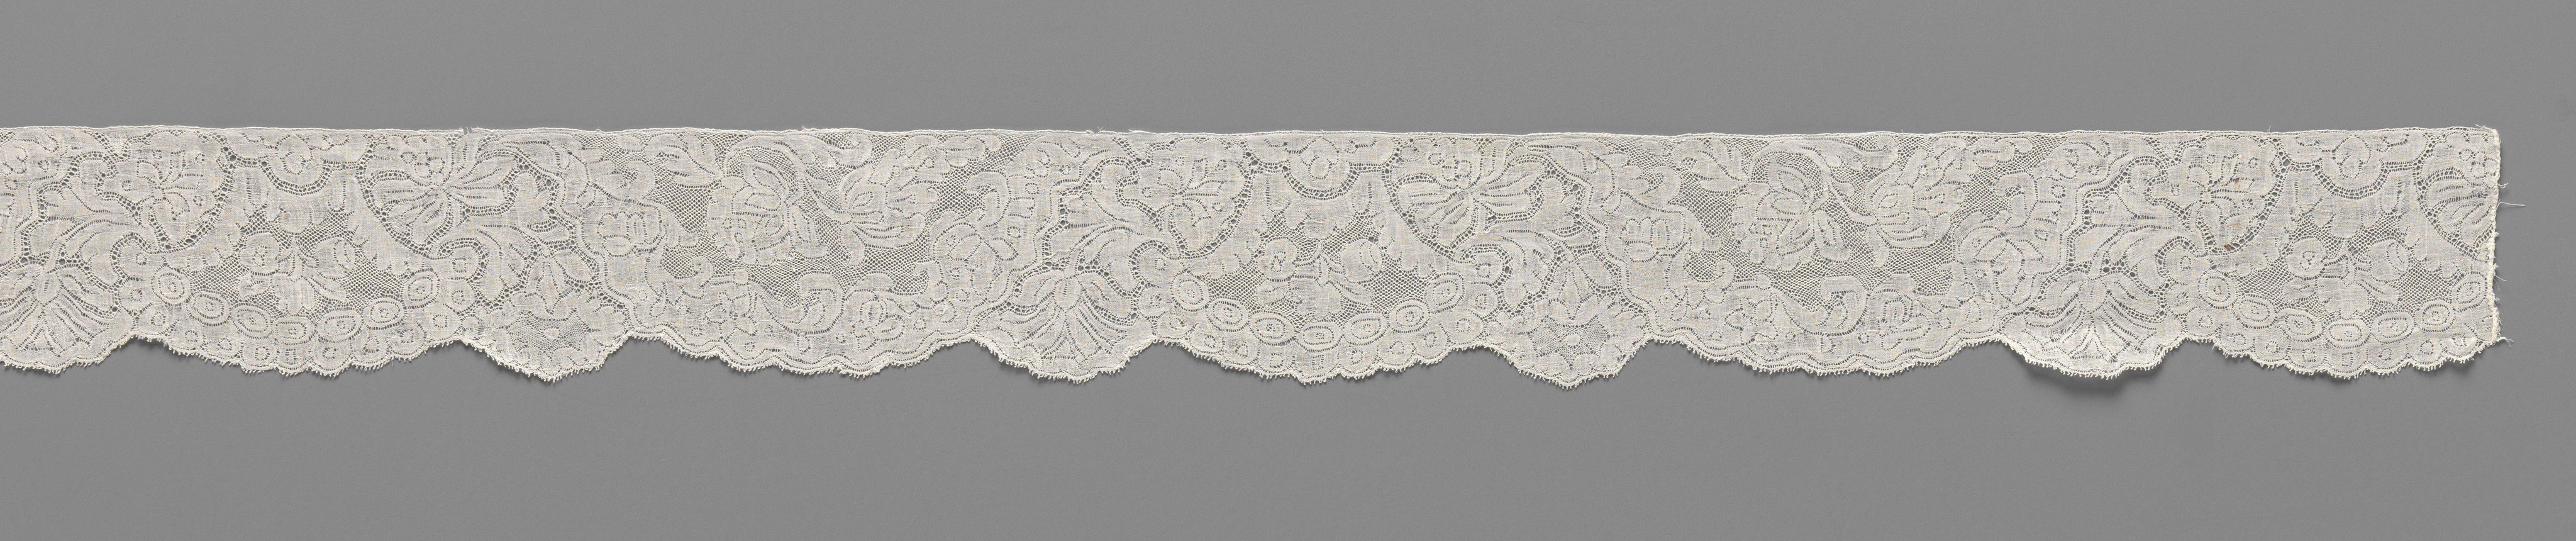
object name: strip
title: Strook kloskant met half cirkelvormig veld en trapeziumvormig cartouche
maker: Anonymous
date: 1730-1740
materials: linen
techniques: lace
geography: valenciennes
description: Strook naturelkleurige kloskant: Valenciennes-kant met Mechelse grond. Het zich herhalende patroon bestaat uit een rijk versierd half cirkelvormig veld gevolgd door een min of meer trapeziumvormig veld. Het halfcirkelvormige veld wordt gevormd door een sierband die van boven- tot onderaan loopt met de ronding naar beneden. In het veld hangt een omkrullende stengel met een pioenroos en een pluimvormige bloem eraan. Het trapeziumvormige veld wordt gevormd door twee schuin naar beneden hangende anjers waartussen een trapeziumvormige cartouche met rond getrokken zijden. De motieven zijn gemaakt in linnenslag met opengewerkte randjes en uitsparingen. In één bloemhart is netslag toegepast als siergrond. Om de schuin naar beneden hangende anjers heen is een tralieslag toegepast om grover opengewerkte contourlijnen te realiseren. De bovenzijde van de strook is recht afgewerkt. De schulpenrand volgt het patroon en is afgewerkt met picots.